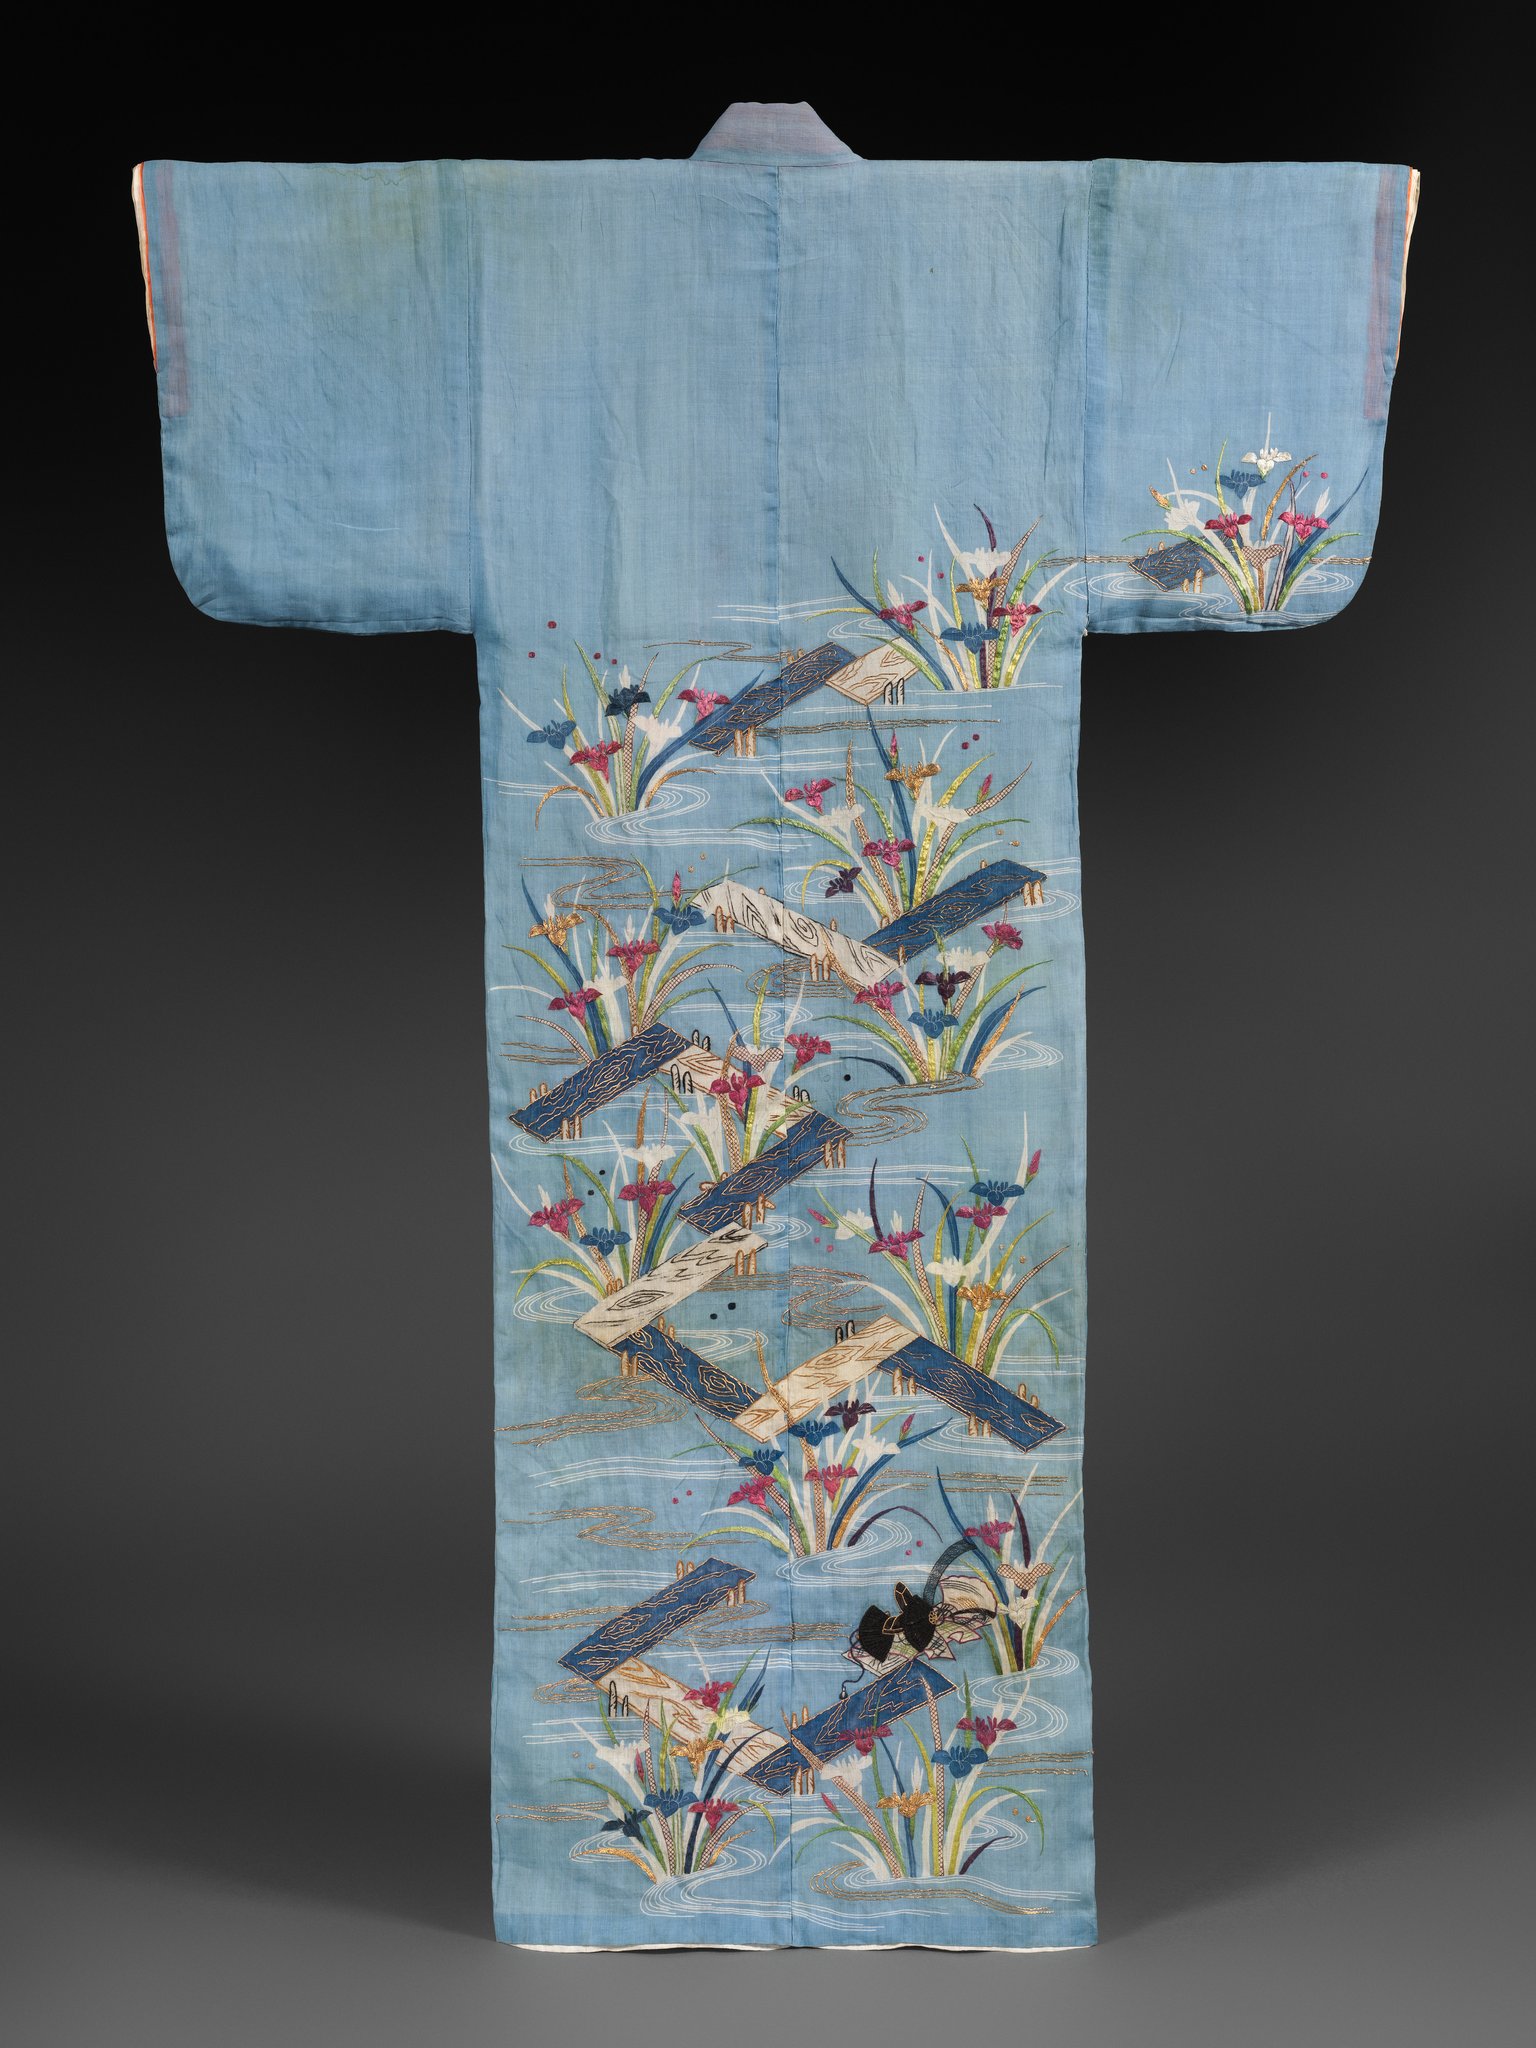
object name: kimono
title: Summer Robe (Katabira) with Irises at Yatsuhashi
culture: japanese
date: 1834-1866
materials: gold thread, paste, silk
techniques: dyeing, embroidery, painting, weave, resist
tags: bridges,flowers